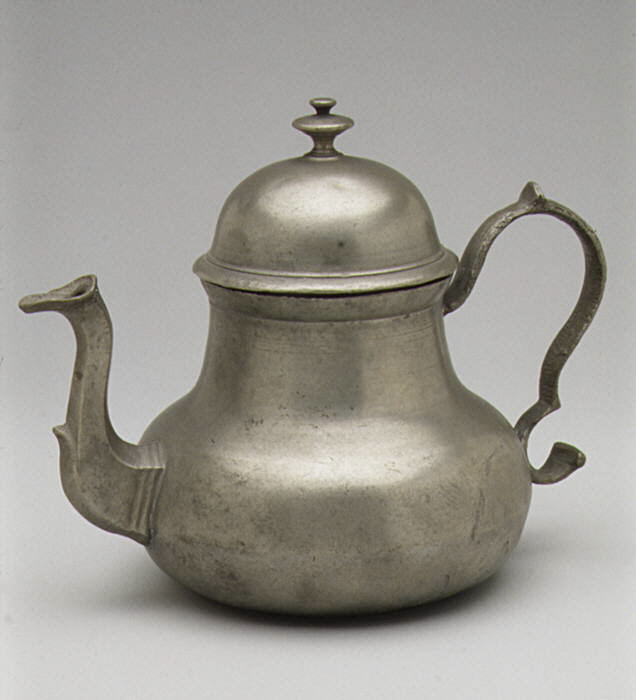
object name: teapot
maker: christian roth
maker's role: maker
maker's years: 1707-1807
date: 1754-1775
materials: pewter